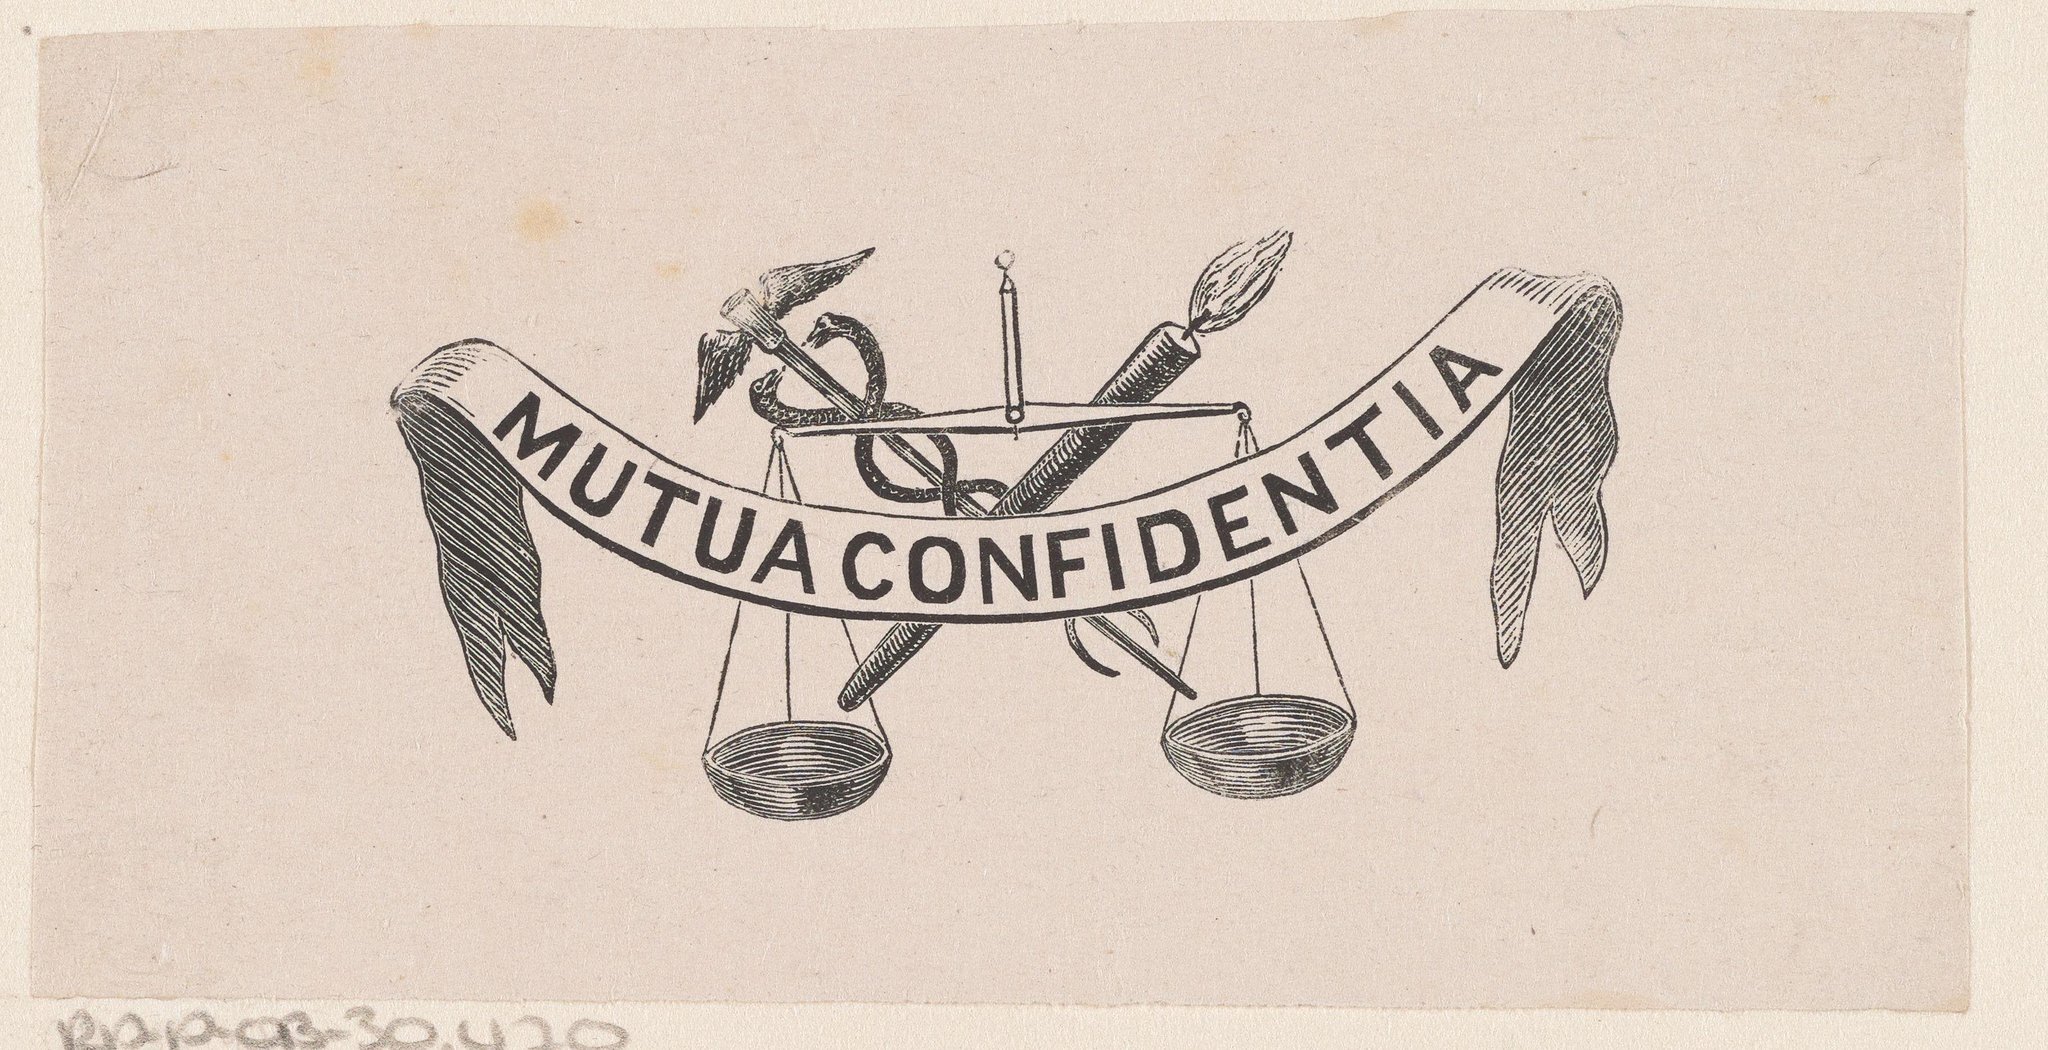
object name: print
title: Vignet met een weegschaal, een Mercuriusstaf en een fakkel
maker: isaac weissenbruch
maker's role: print maker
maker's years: 1826-1912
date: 1836-1912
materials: paper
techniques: engraving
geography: netherlands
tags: torch, scales, caduceus (staff with two snakes, attribute of mercury), vignette